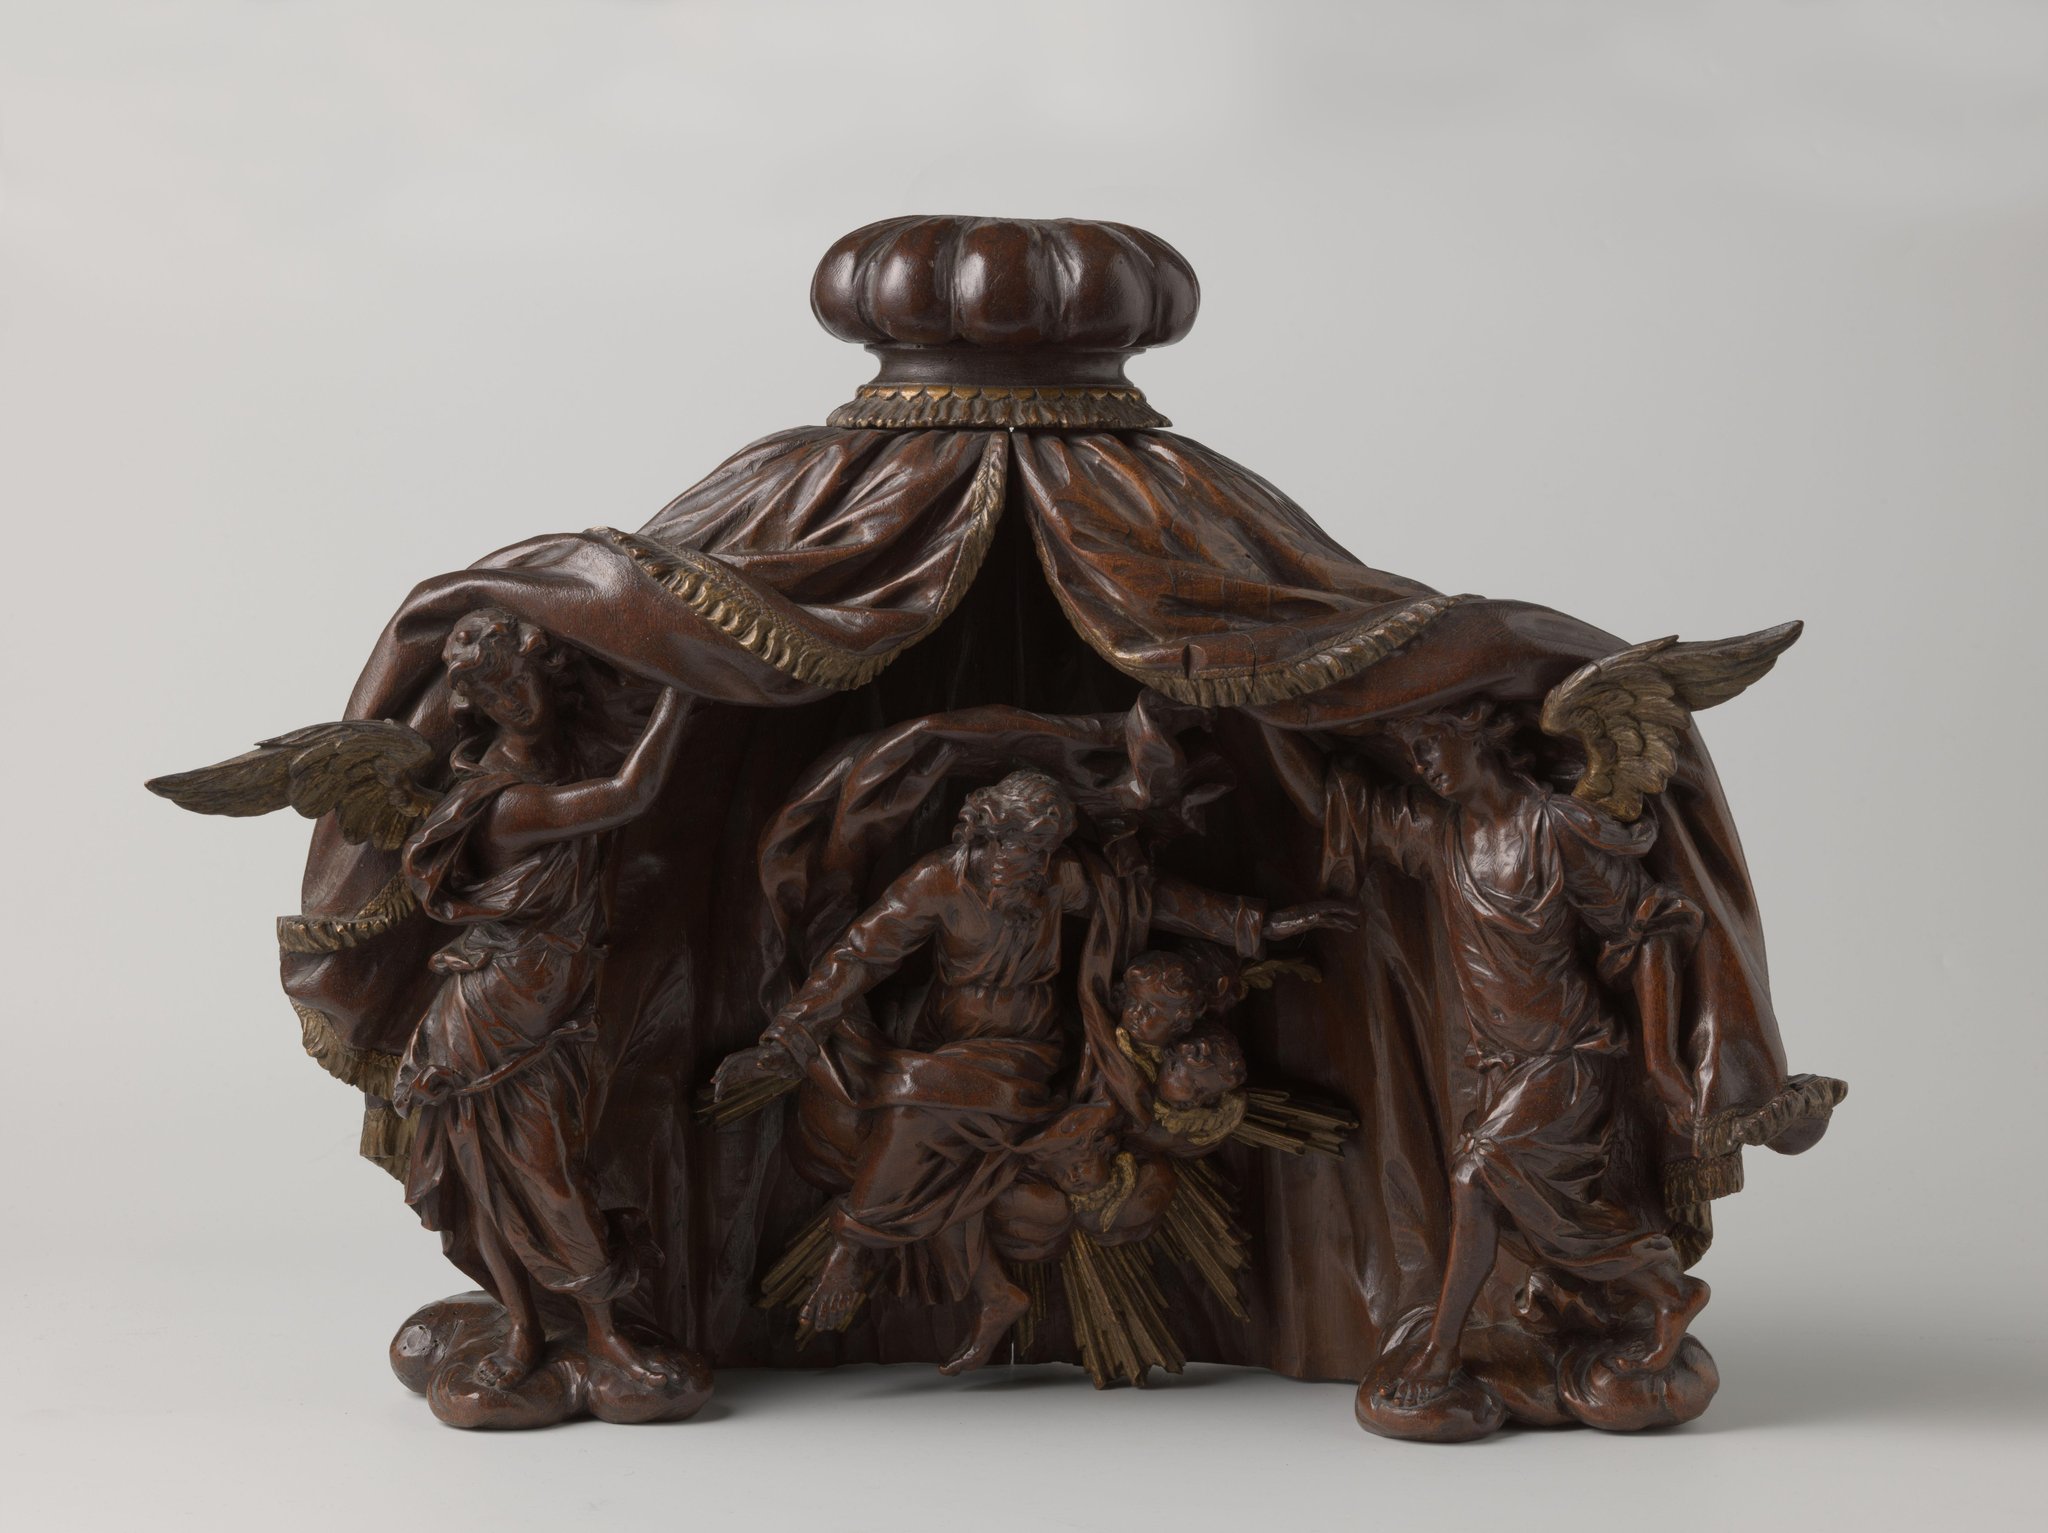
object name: altar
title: Architraaf van devotie-altaar met Maria en Christuskind tussen twee engelen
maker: Anonymous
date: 1700-1750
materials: wood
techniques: gilding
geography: mechelen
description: Huisaltaar met Maria en Christuskind tussen twee engelen. Het Christuskind staat op een hoge sokkel. Boven Maria en het Kind zit God geflankeerd door twee engelen die een baldakijn boven Hem ophouden. Op verschillende plaatsen is het hout verguld.